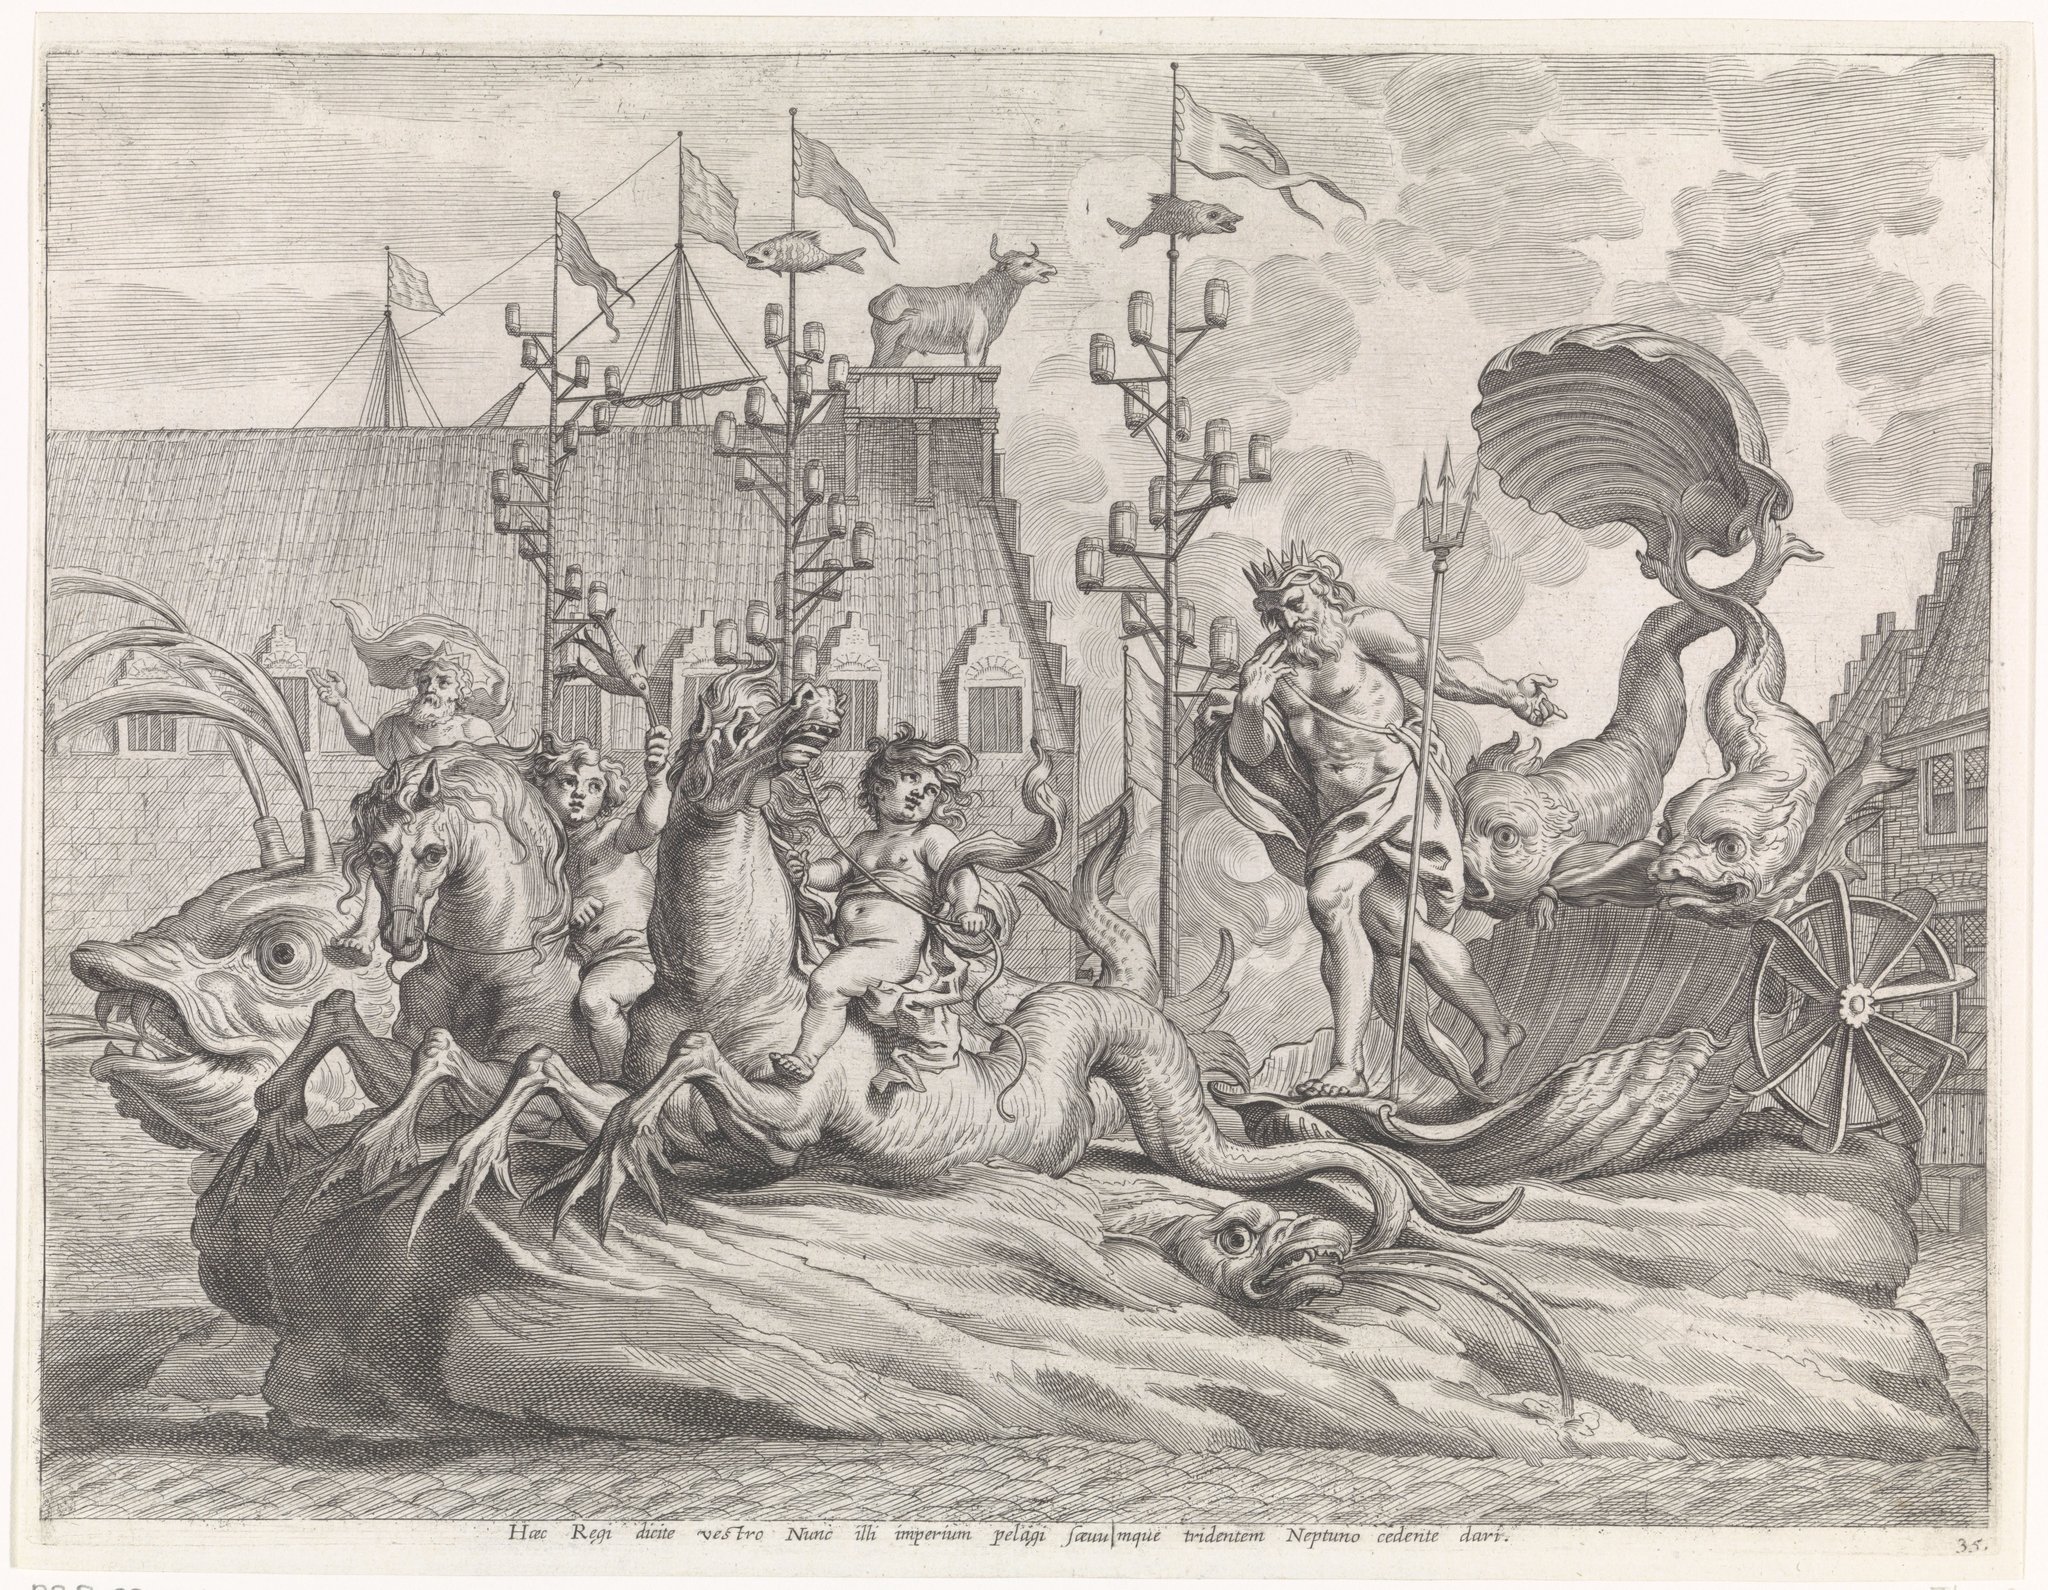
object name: print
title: Blijde intrede van de Kardinaal-Infant te Gent, 1635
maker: pieter de jode (ii)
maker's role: draughtsman, print maker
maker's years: 1606-1674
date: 1636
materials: paper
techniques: engraving, etching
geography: antwerp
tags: filips iv (koning van spanje), landvoogd der zuidelijke nederlanden ferdinand van oostenrijk, specific aspects, allegorical aspects of neptune; neptune as patron, other decorative structures (~ triumphal entry, etc.), ghent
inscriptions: collector's mark: Lugt 240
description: Spektakel met Neptunus (Filips IV) staande in zijn strijdwagen getrokken door zeepaarden. Stellage opgesteld op een plein te Gent. Op de achtergrond de stellage met de reuzenvis, huizen en masten met brandende pektonnen. In de marge een onderschrift in het Latijn. Vijfendertigste prent uit een serie van 42 die de uitgave van de beschrijving van de intocht van de Kardinaal Infant Ferdinand van Oostenrijk te Gent op 28 januari 1635 als de nieuwe landvoogd voor de Spaanse Nederlanden illustreren.